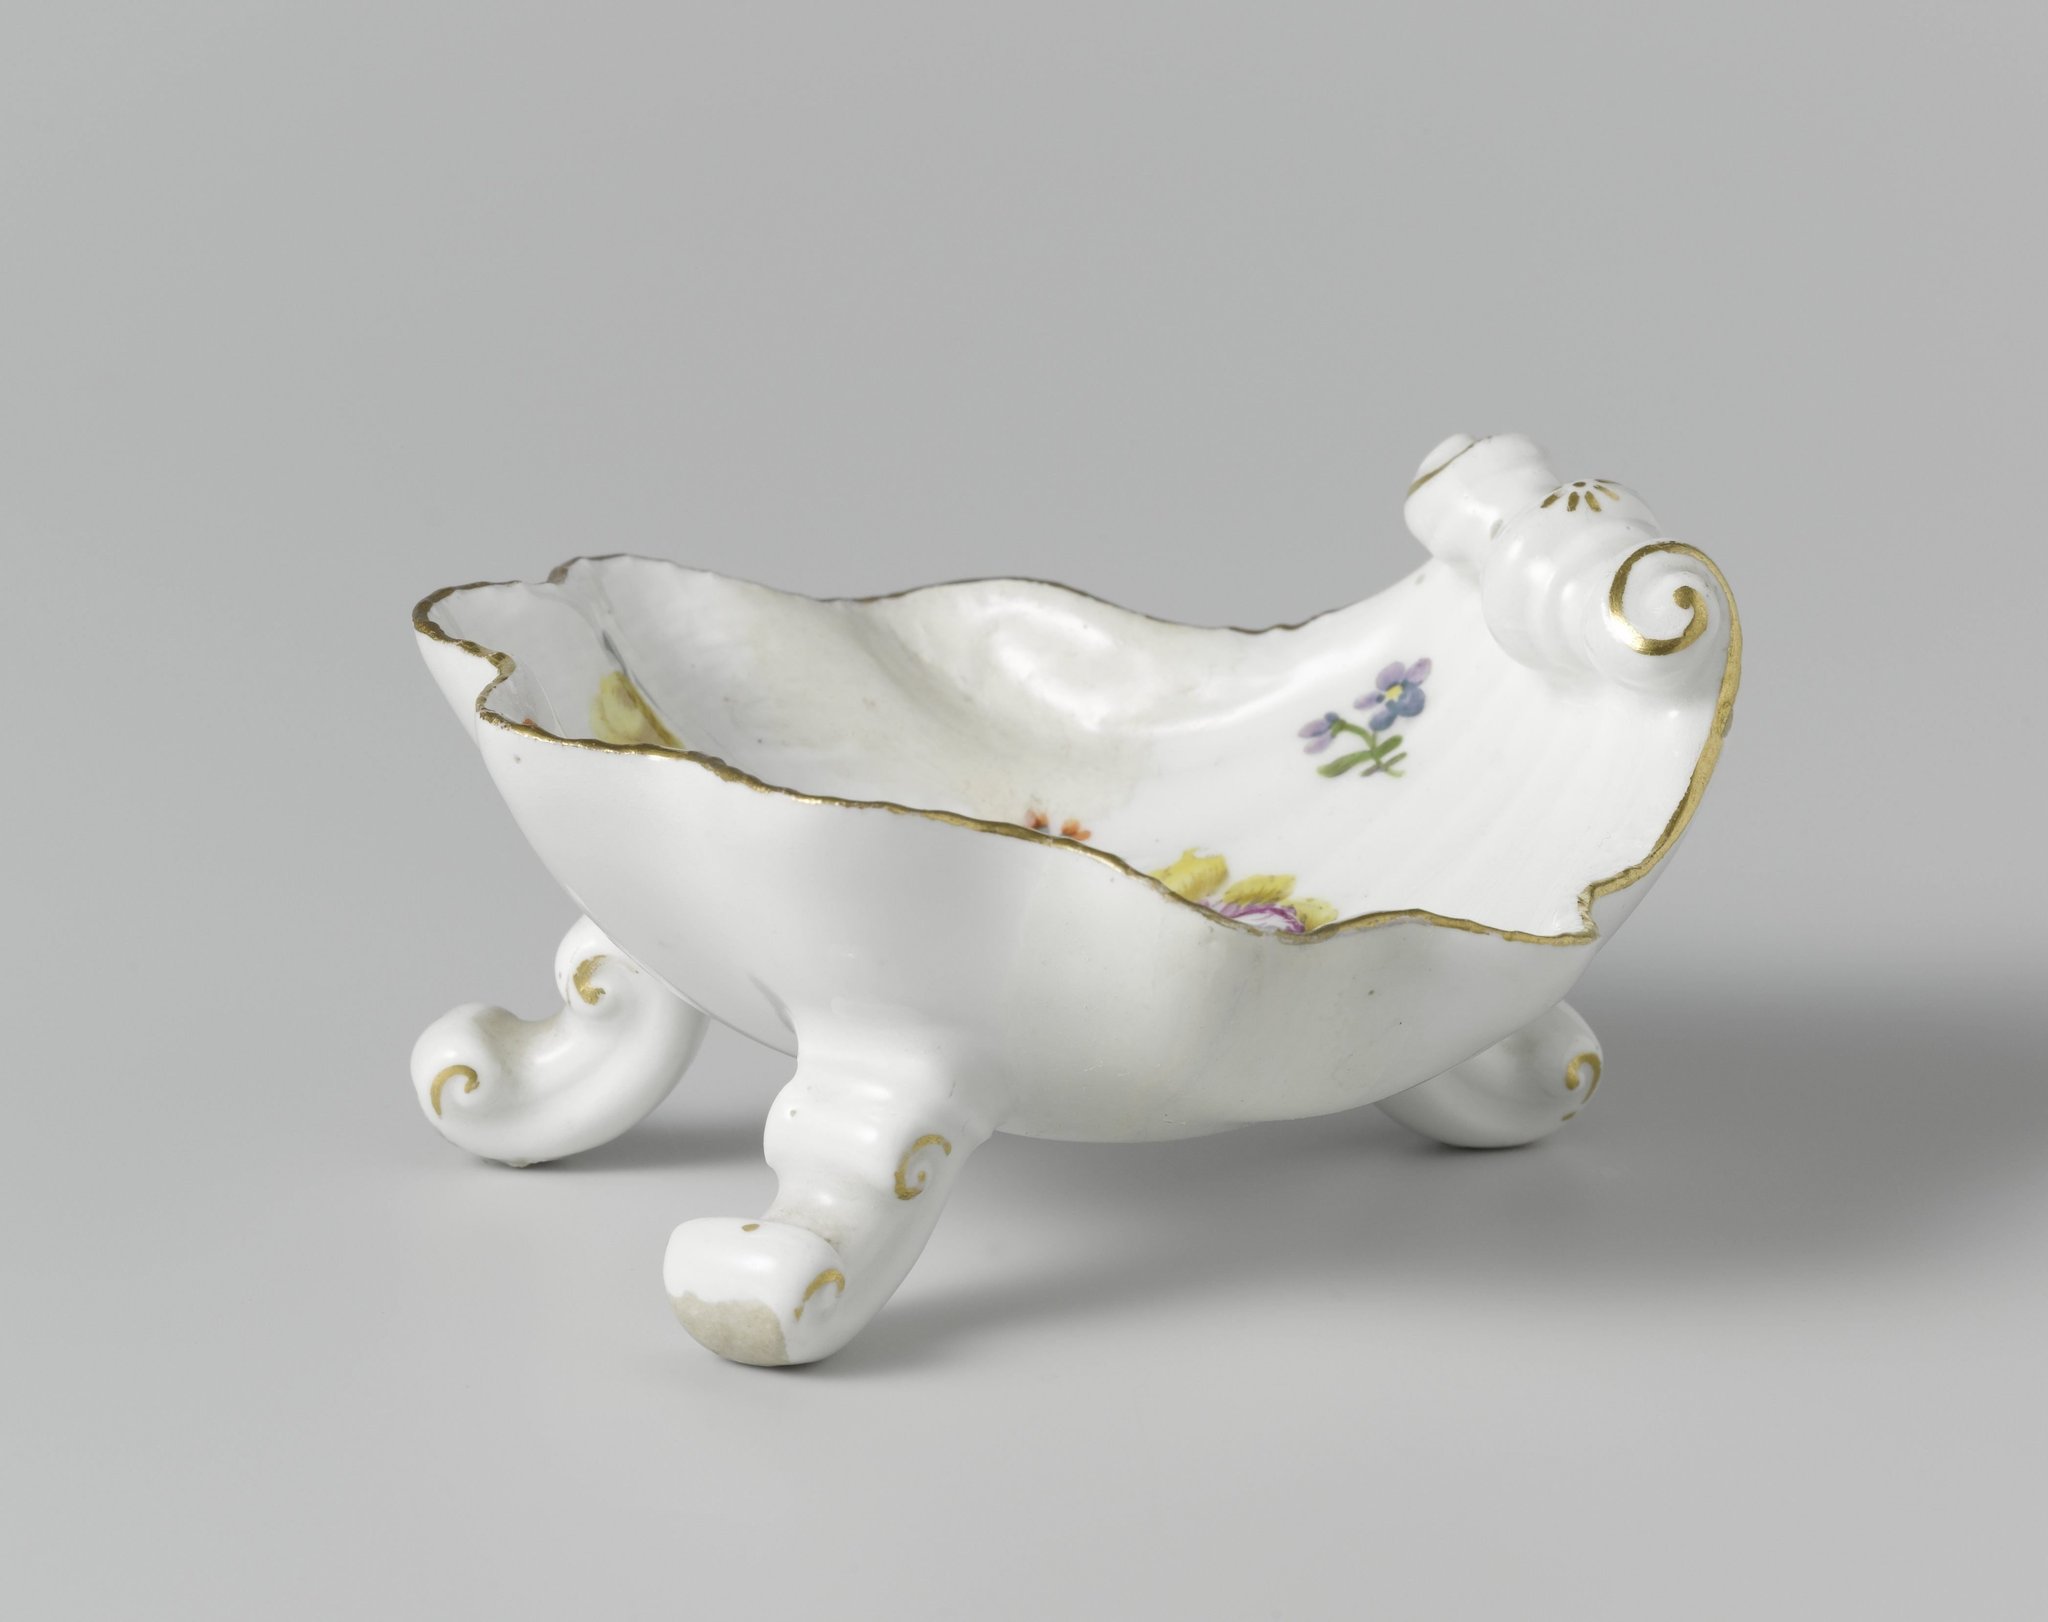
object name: salt condiment vessel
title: Zoutvat, veelkleurig beschilderd met Deutsche Blumen, insekten en vruchten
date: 1750-1760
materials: porcelain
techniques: painted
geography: meissen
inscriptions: factory mark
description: Zoutvat van beschilderd porselein. Het zoutvat heeft de vorm van een schelp met een geschulpte rand en staat op drie voluutvormige poten. Het zoutvat is beschilderd met Deutsche Blumen, insekten en vruchten. De rand is versierd met het Neuozier-patroon in reliëf. Het zoutvat is gemerkt en hoort bij een servies (BK-17474-1 t/m BK-17474-253).